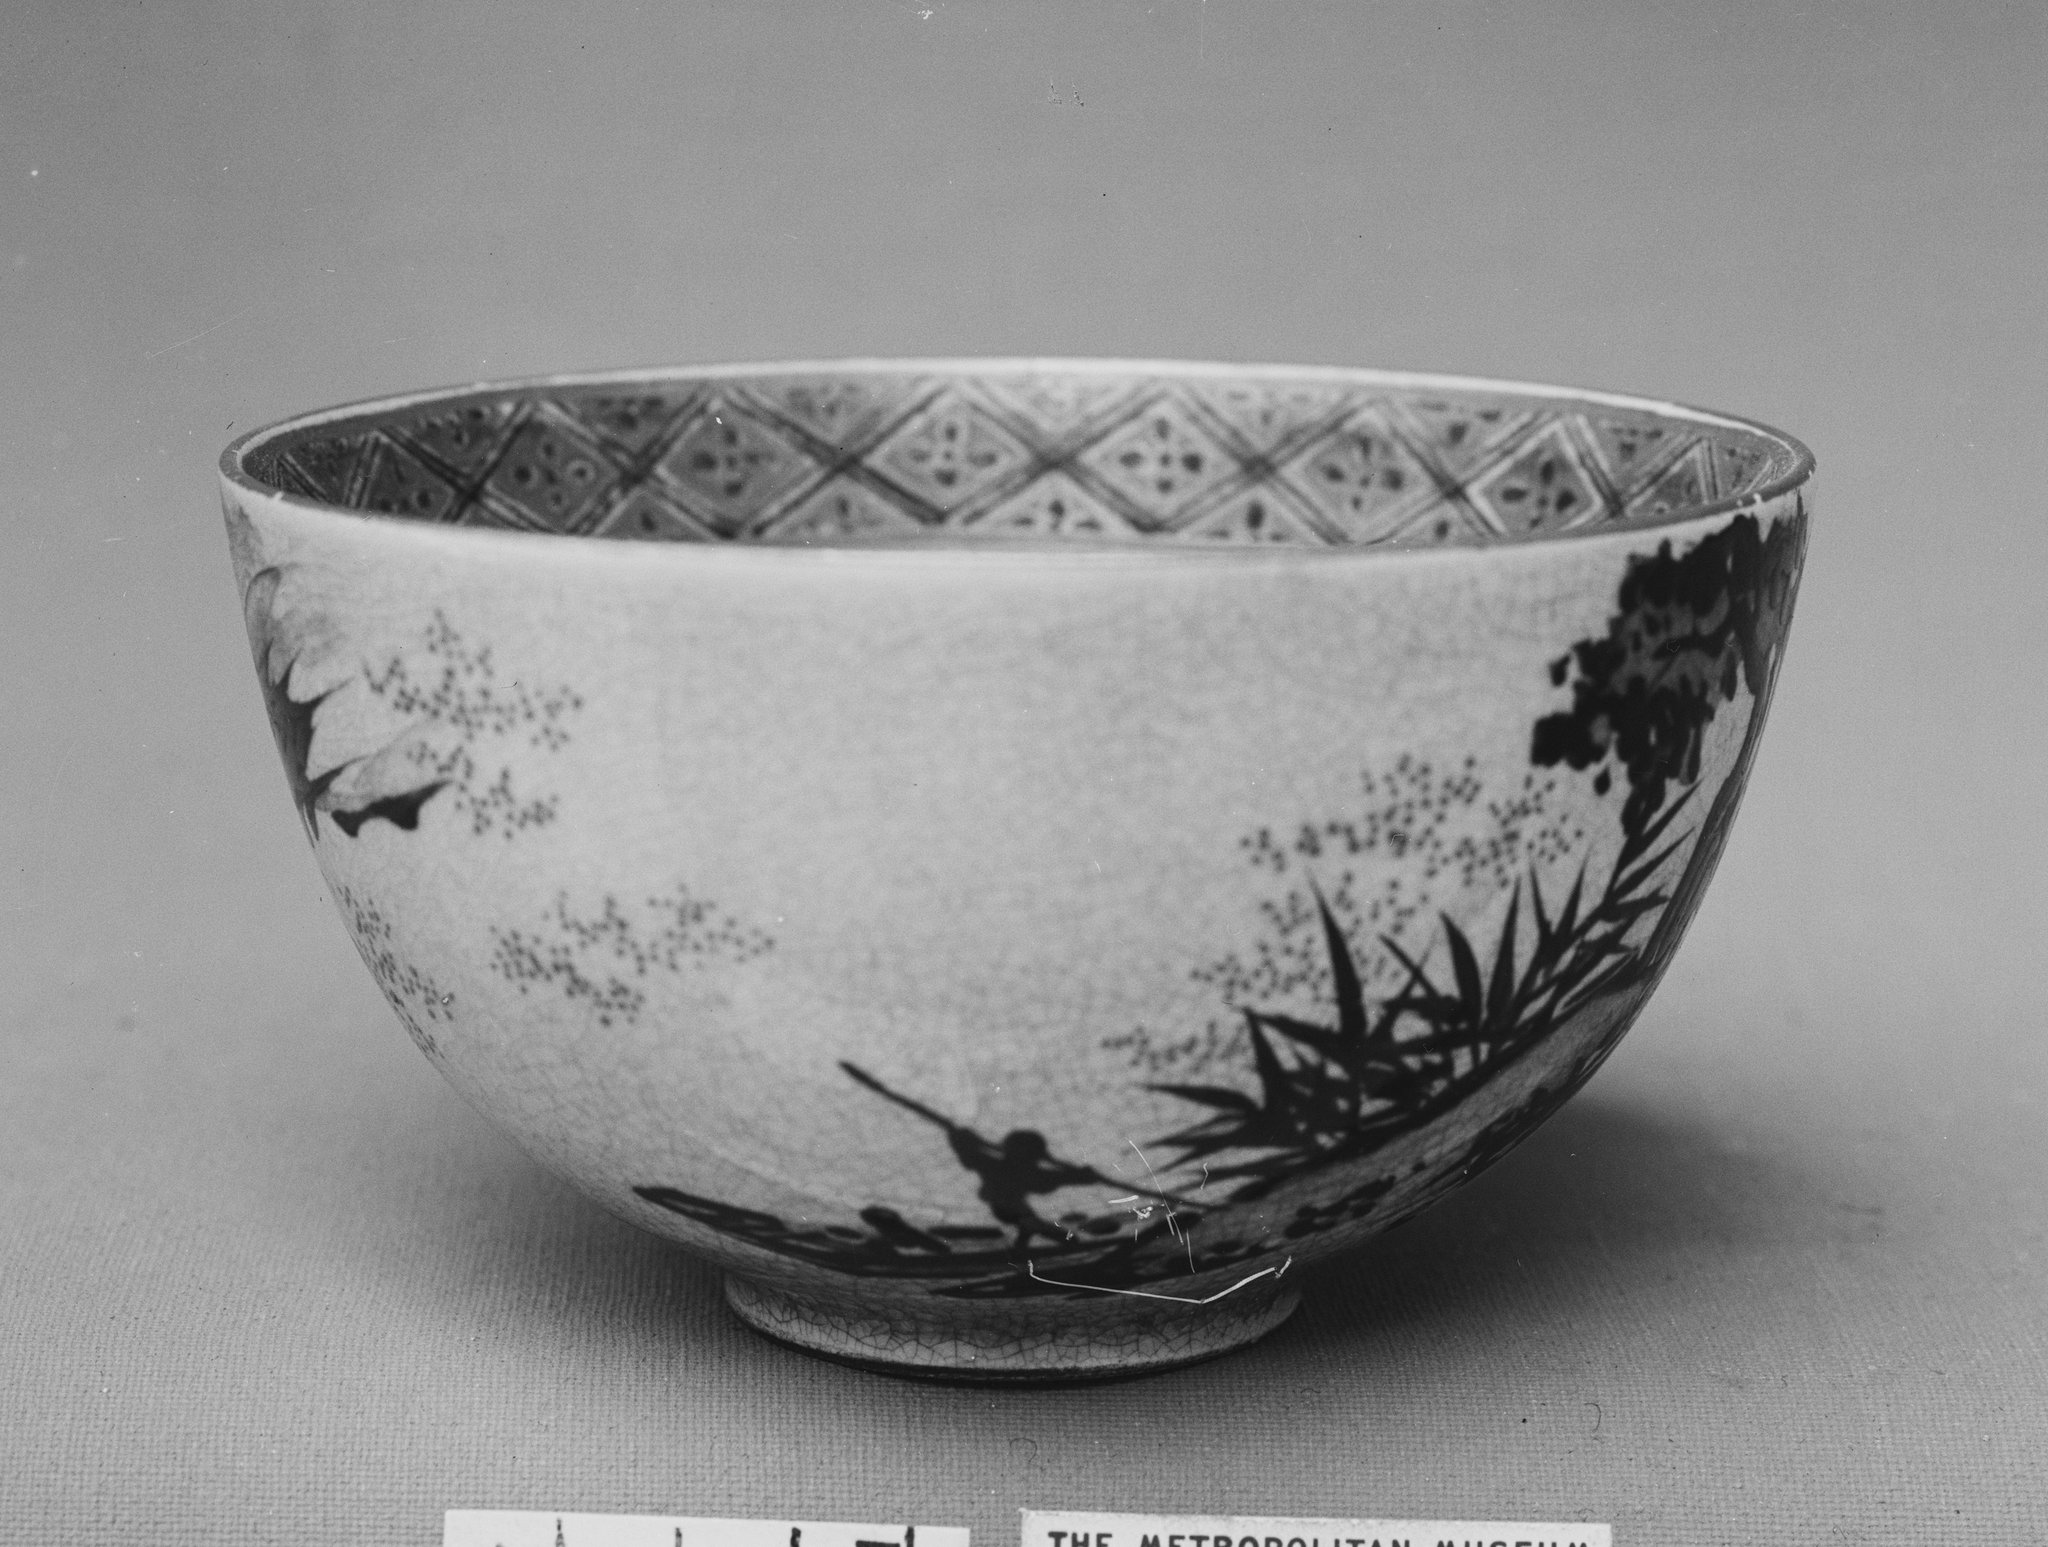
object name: bowl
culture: japanese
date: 1800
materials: enamel, glaze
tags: human figures,leaves